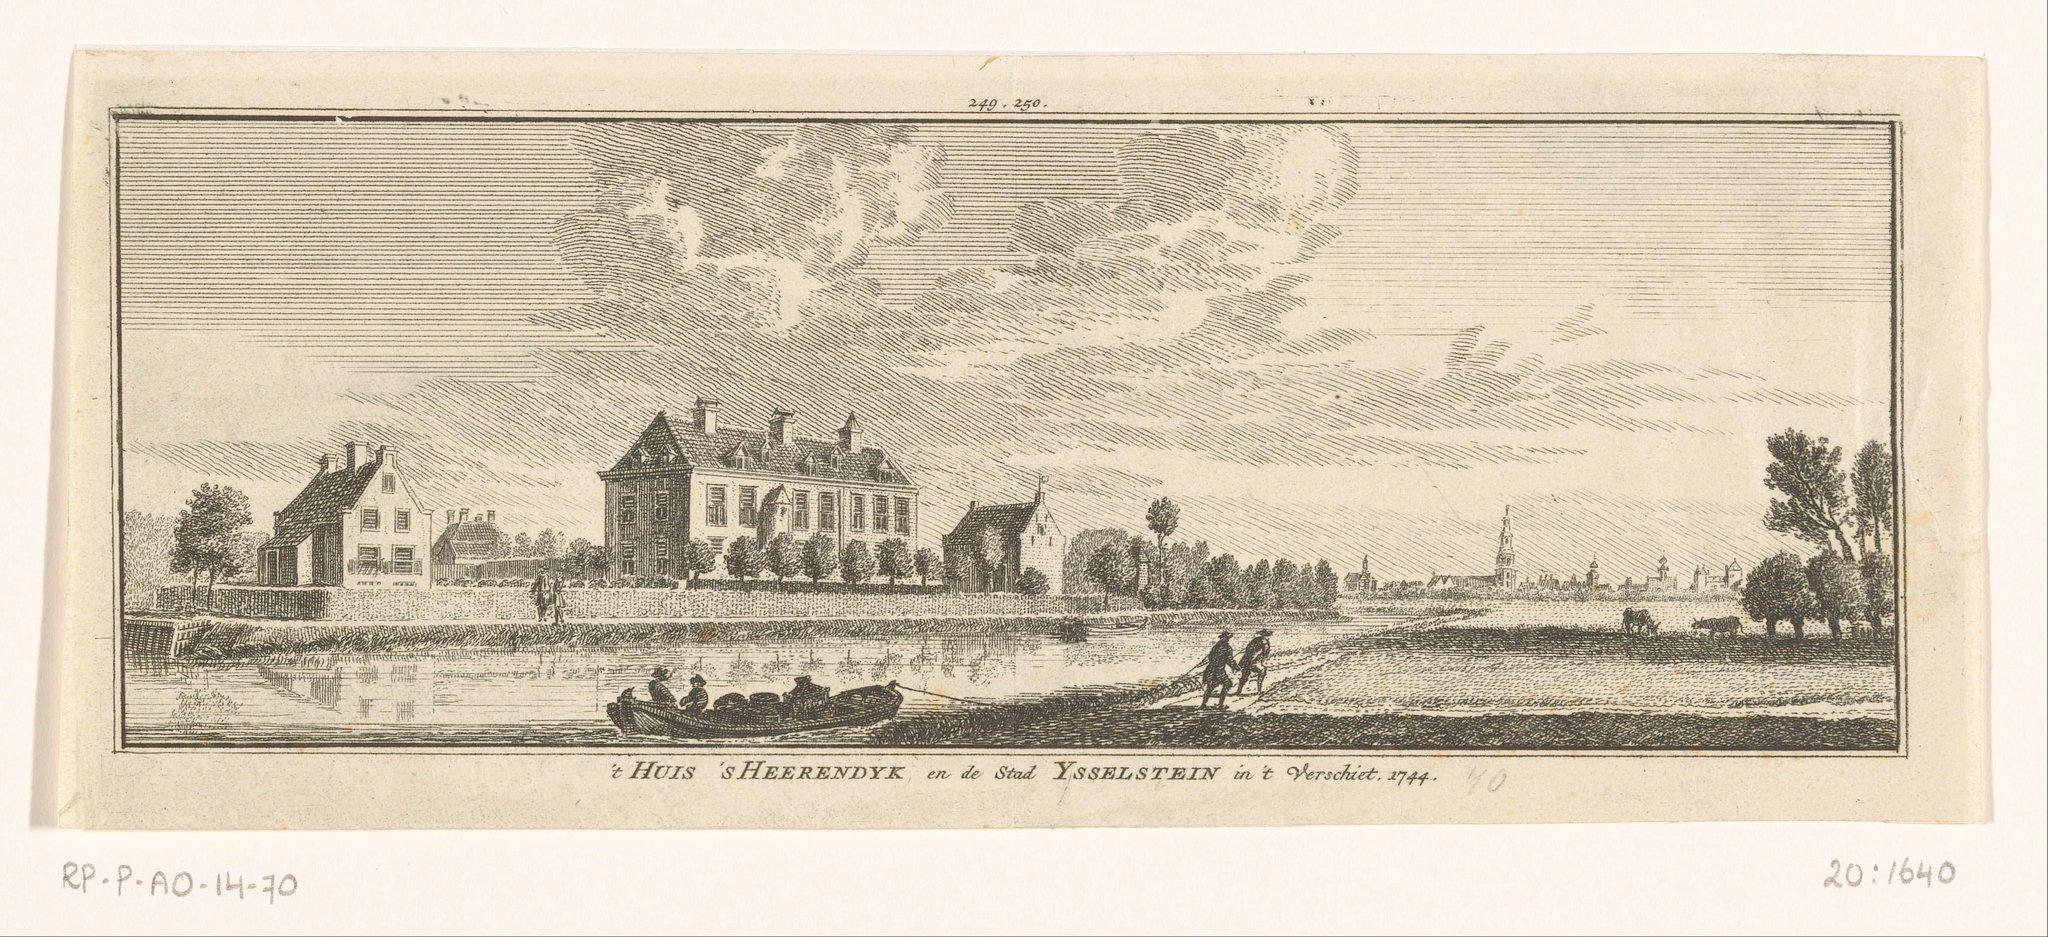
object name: print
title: Gezicht op Huis 's Heerendijk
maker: hendrik spilman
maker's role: draughtsman, painter, print maker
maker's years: 1721-1784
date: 1750-1792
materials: paper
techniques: engraving, etching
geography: haarlem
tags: prospect of city, town panorama, silhouette of city, country-house, boat propelled by man or animal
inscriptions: collector's mark: Lugt 2233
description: Prent ook gebruikt in: Het verheerlykt Nederland of kabinet van hedendaagsche gezigten van steden, dorpen (…). 9 delen. Amsterdam: Isaak Tirion en weduwe Isaak Tirion, 1745-1774, dl. 3 (1750), ill. 249-250. Of in: Nederlandsche tafereelen; of eene keurige verzameling van negen honderd fraaije gezigten van steden, dorpen, sloten, oudheden (….). 9 delen. Amsterdam: Jan de Groot, 1792, dl. 3, ill. 249-250.